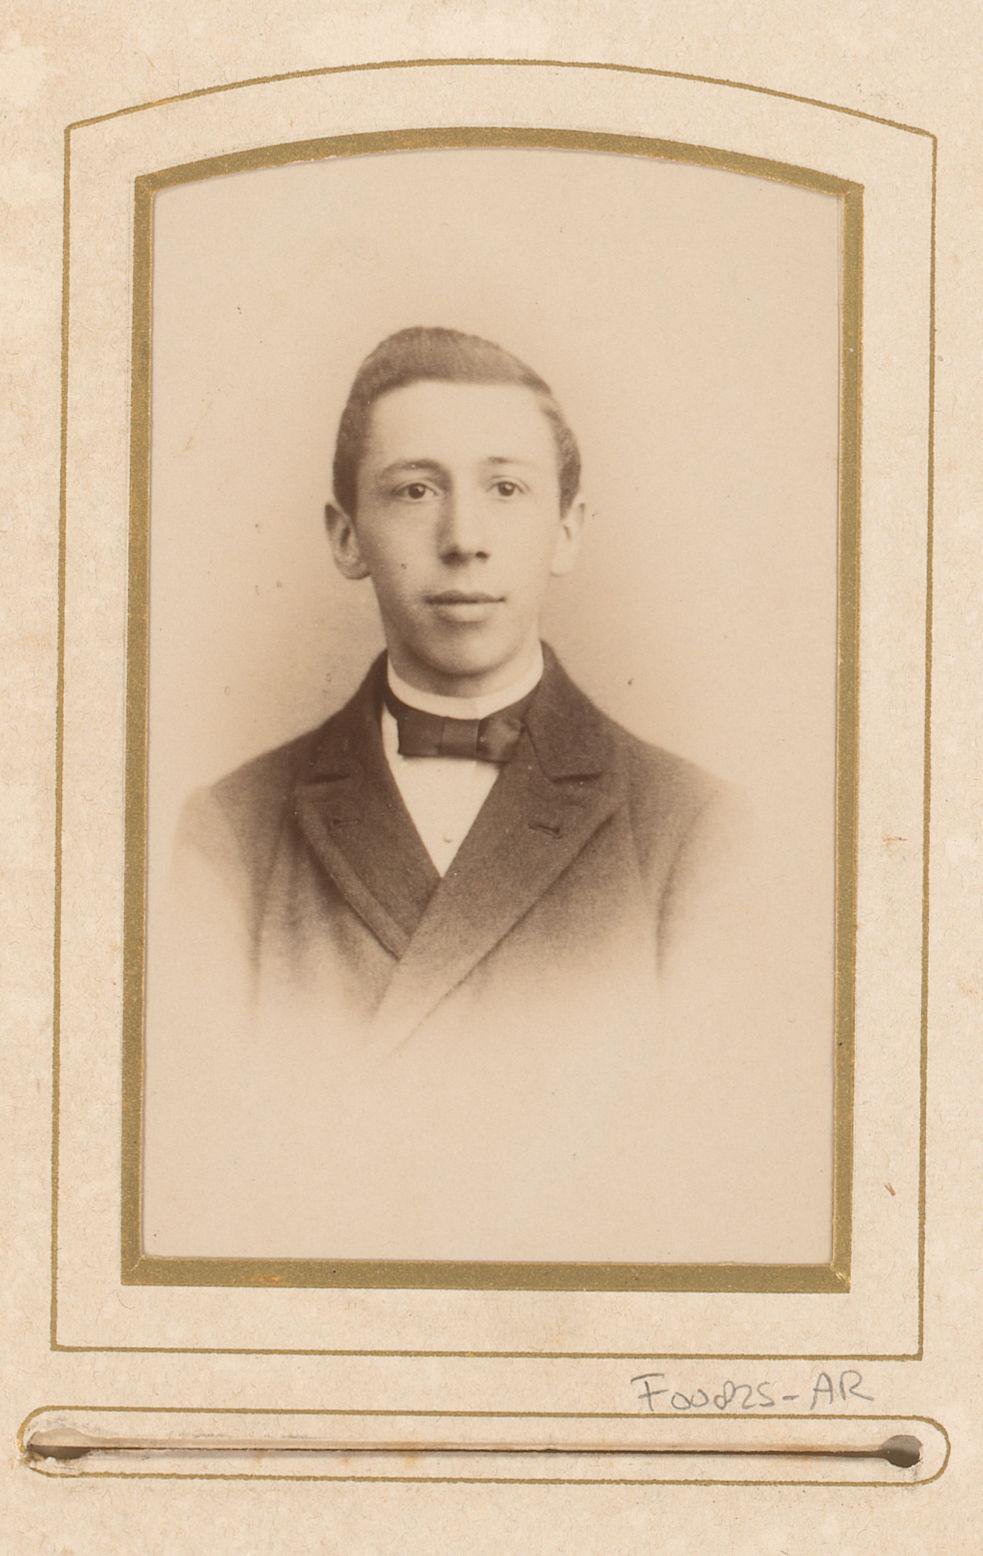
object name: album leaf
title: Portret van een jonge man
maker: august ferdinand heinrich harms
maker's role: fotograaf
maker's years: 1845-1916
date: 1884-1900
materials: cardboard, photographic support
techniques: albumen print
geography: haarlem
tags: historical persons, youth, adolescent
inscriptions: inscription: ‘A.F.H. Harms/ Haarlem/ Zylweg 75.’